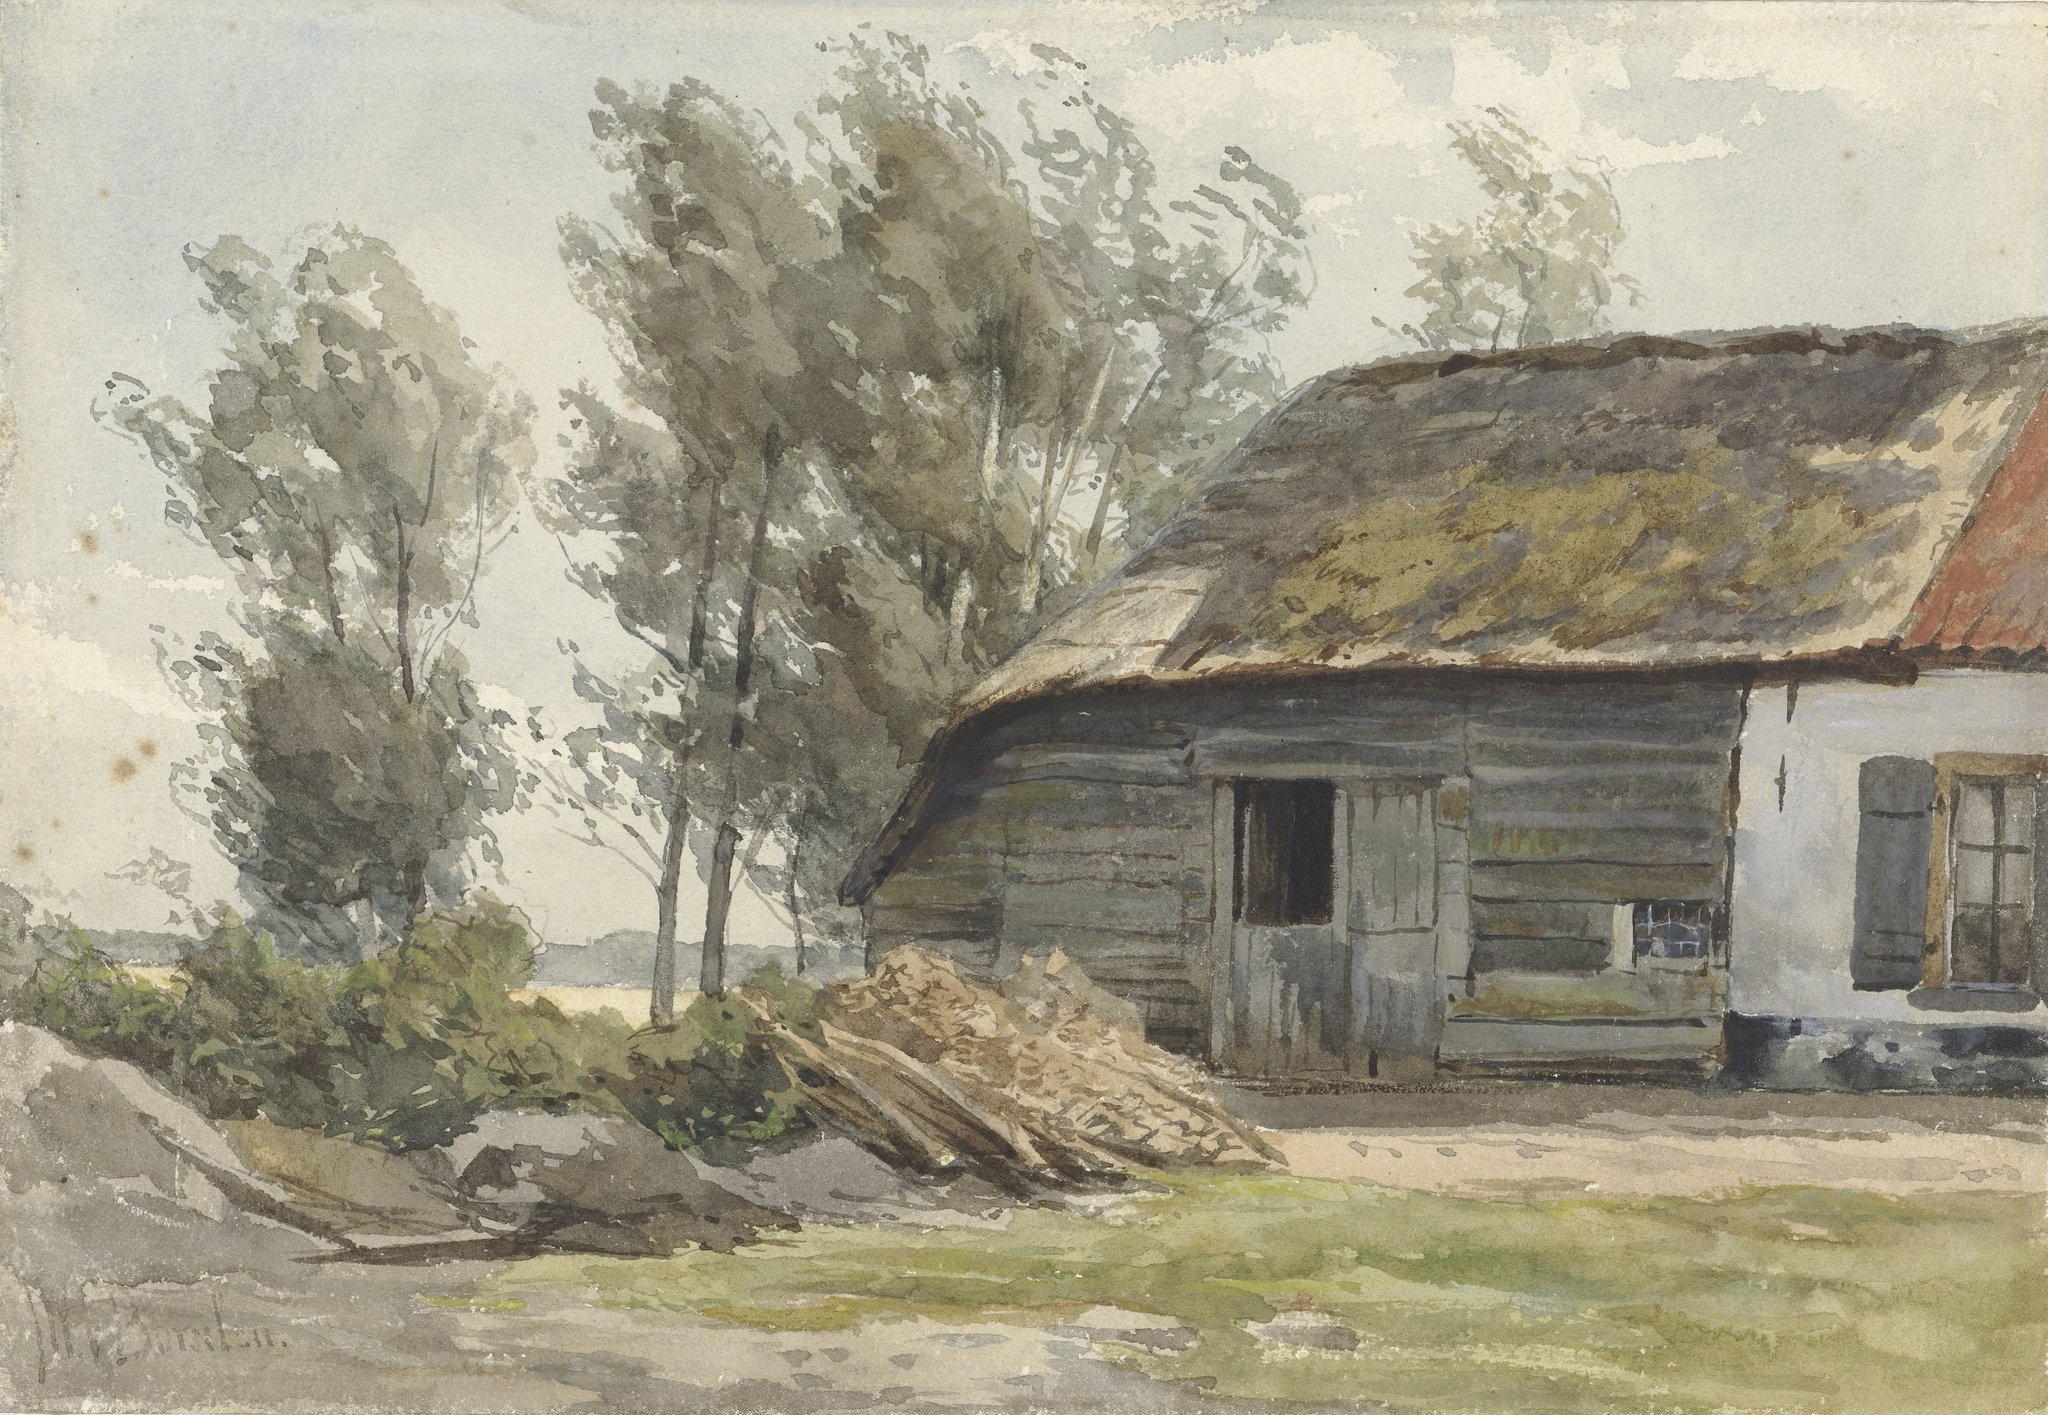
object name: drawing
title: Boerenhofstede met schuur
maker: jan willem van borselen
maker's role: draughtsman, print maker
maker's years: 1825-1892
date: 1835-1892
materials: paper, pencil, watercolor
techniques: brush